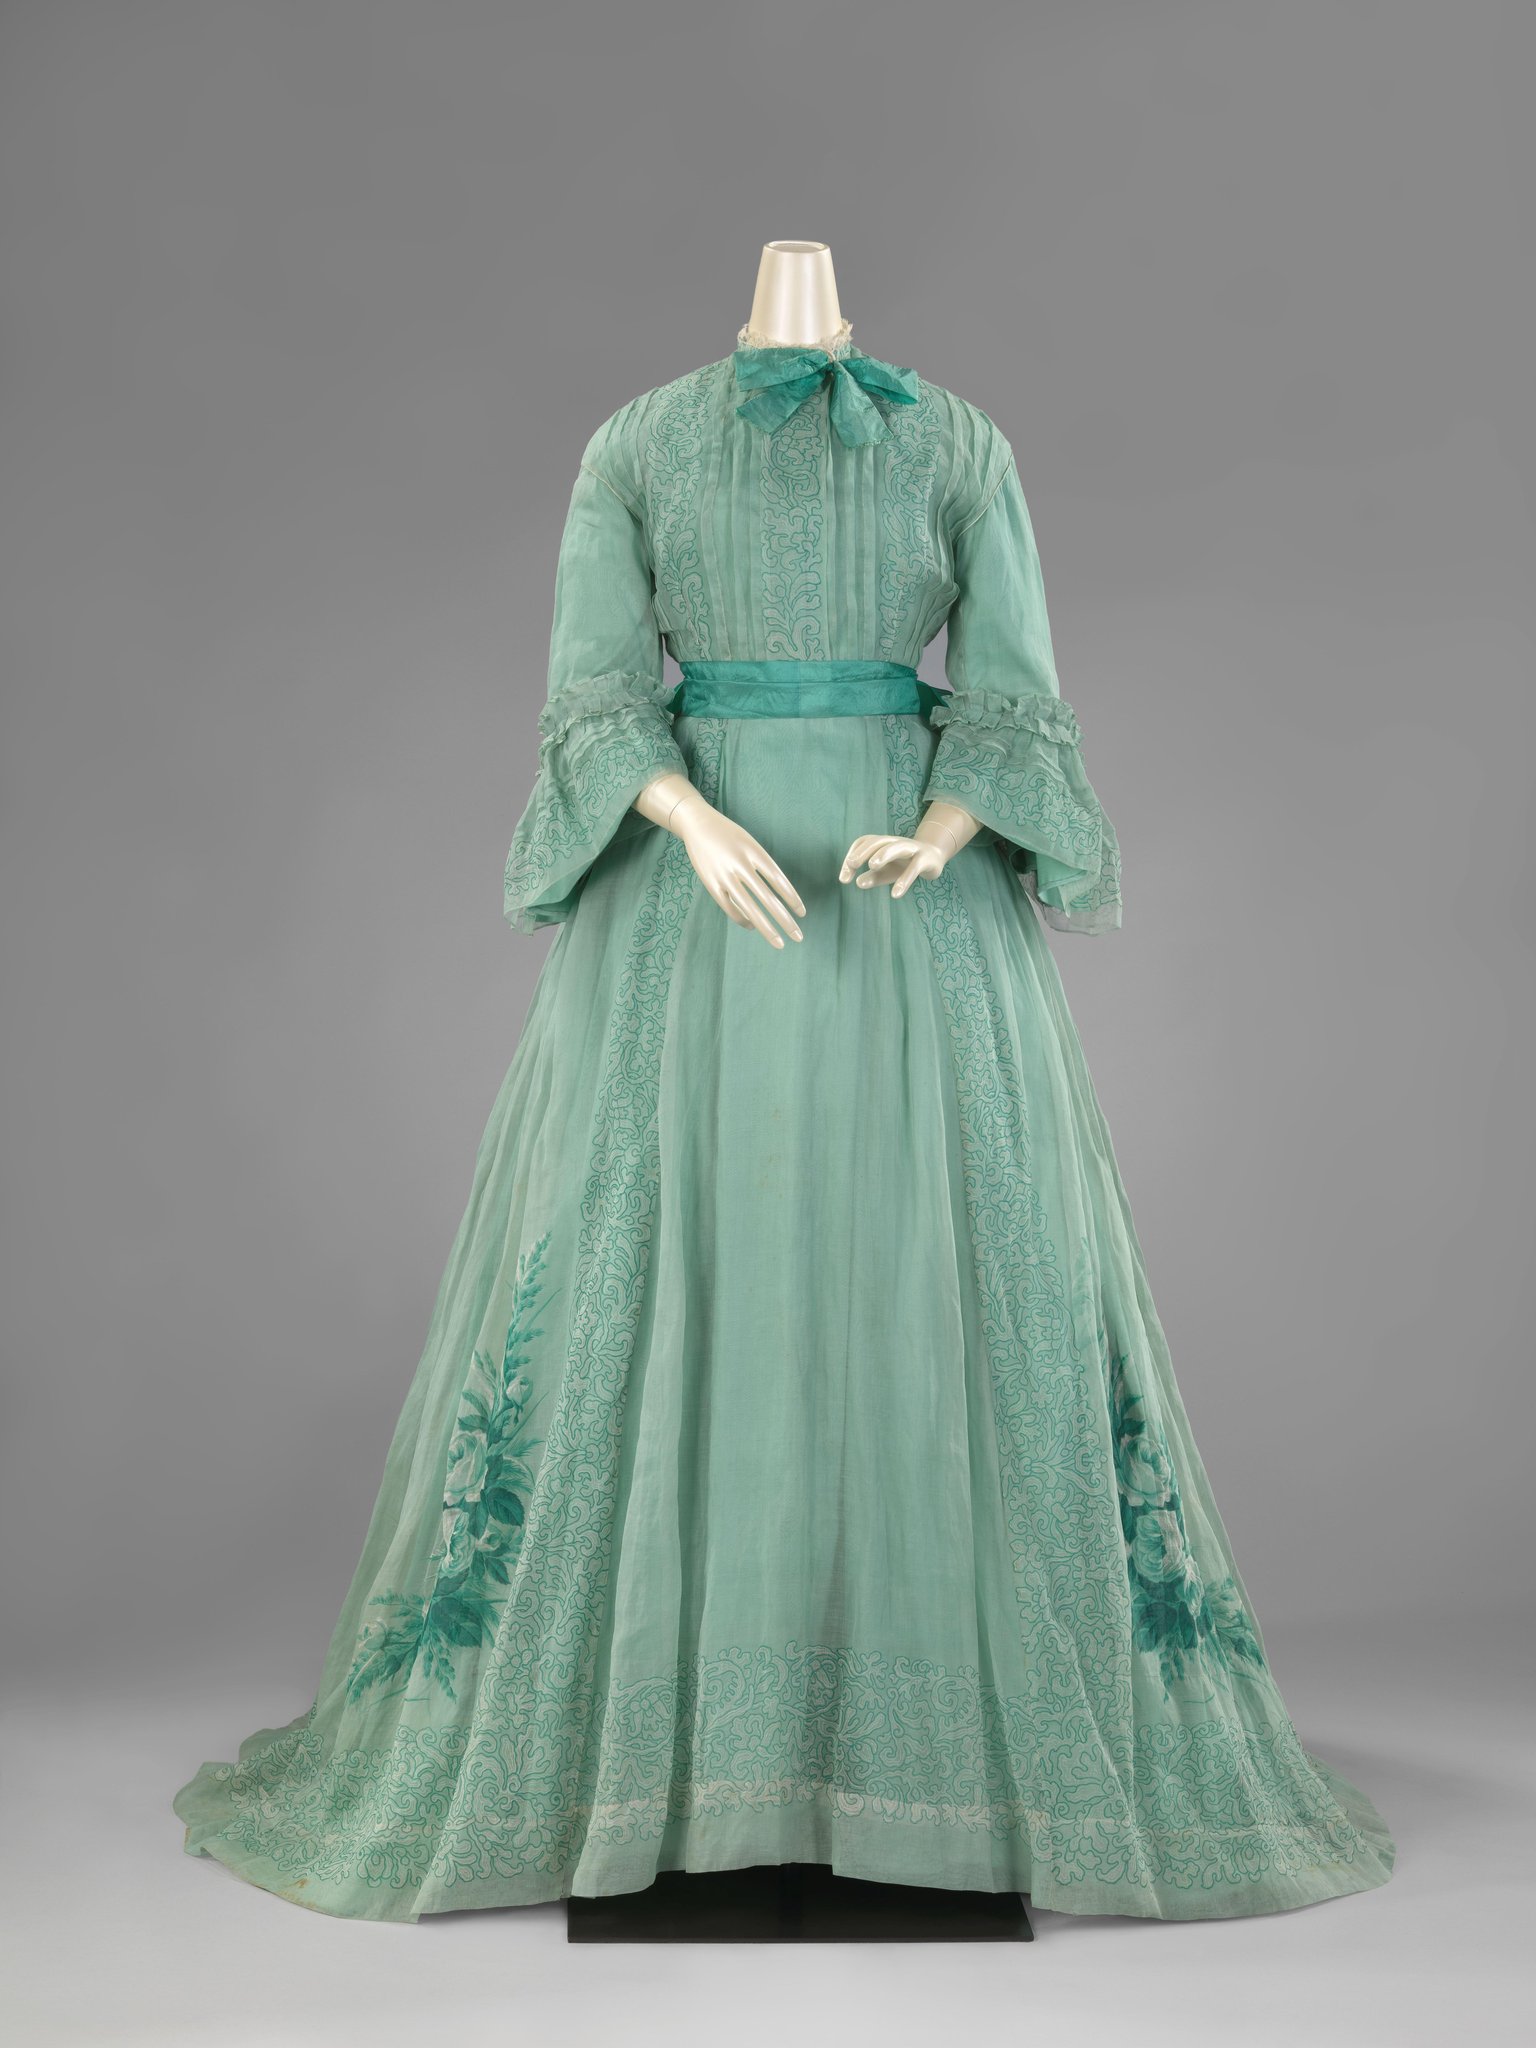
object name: ribbon material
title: Stuk lint van groene zijde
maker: Anonymous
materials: silk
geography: europe